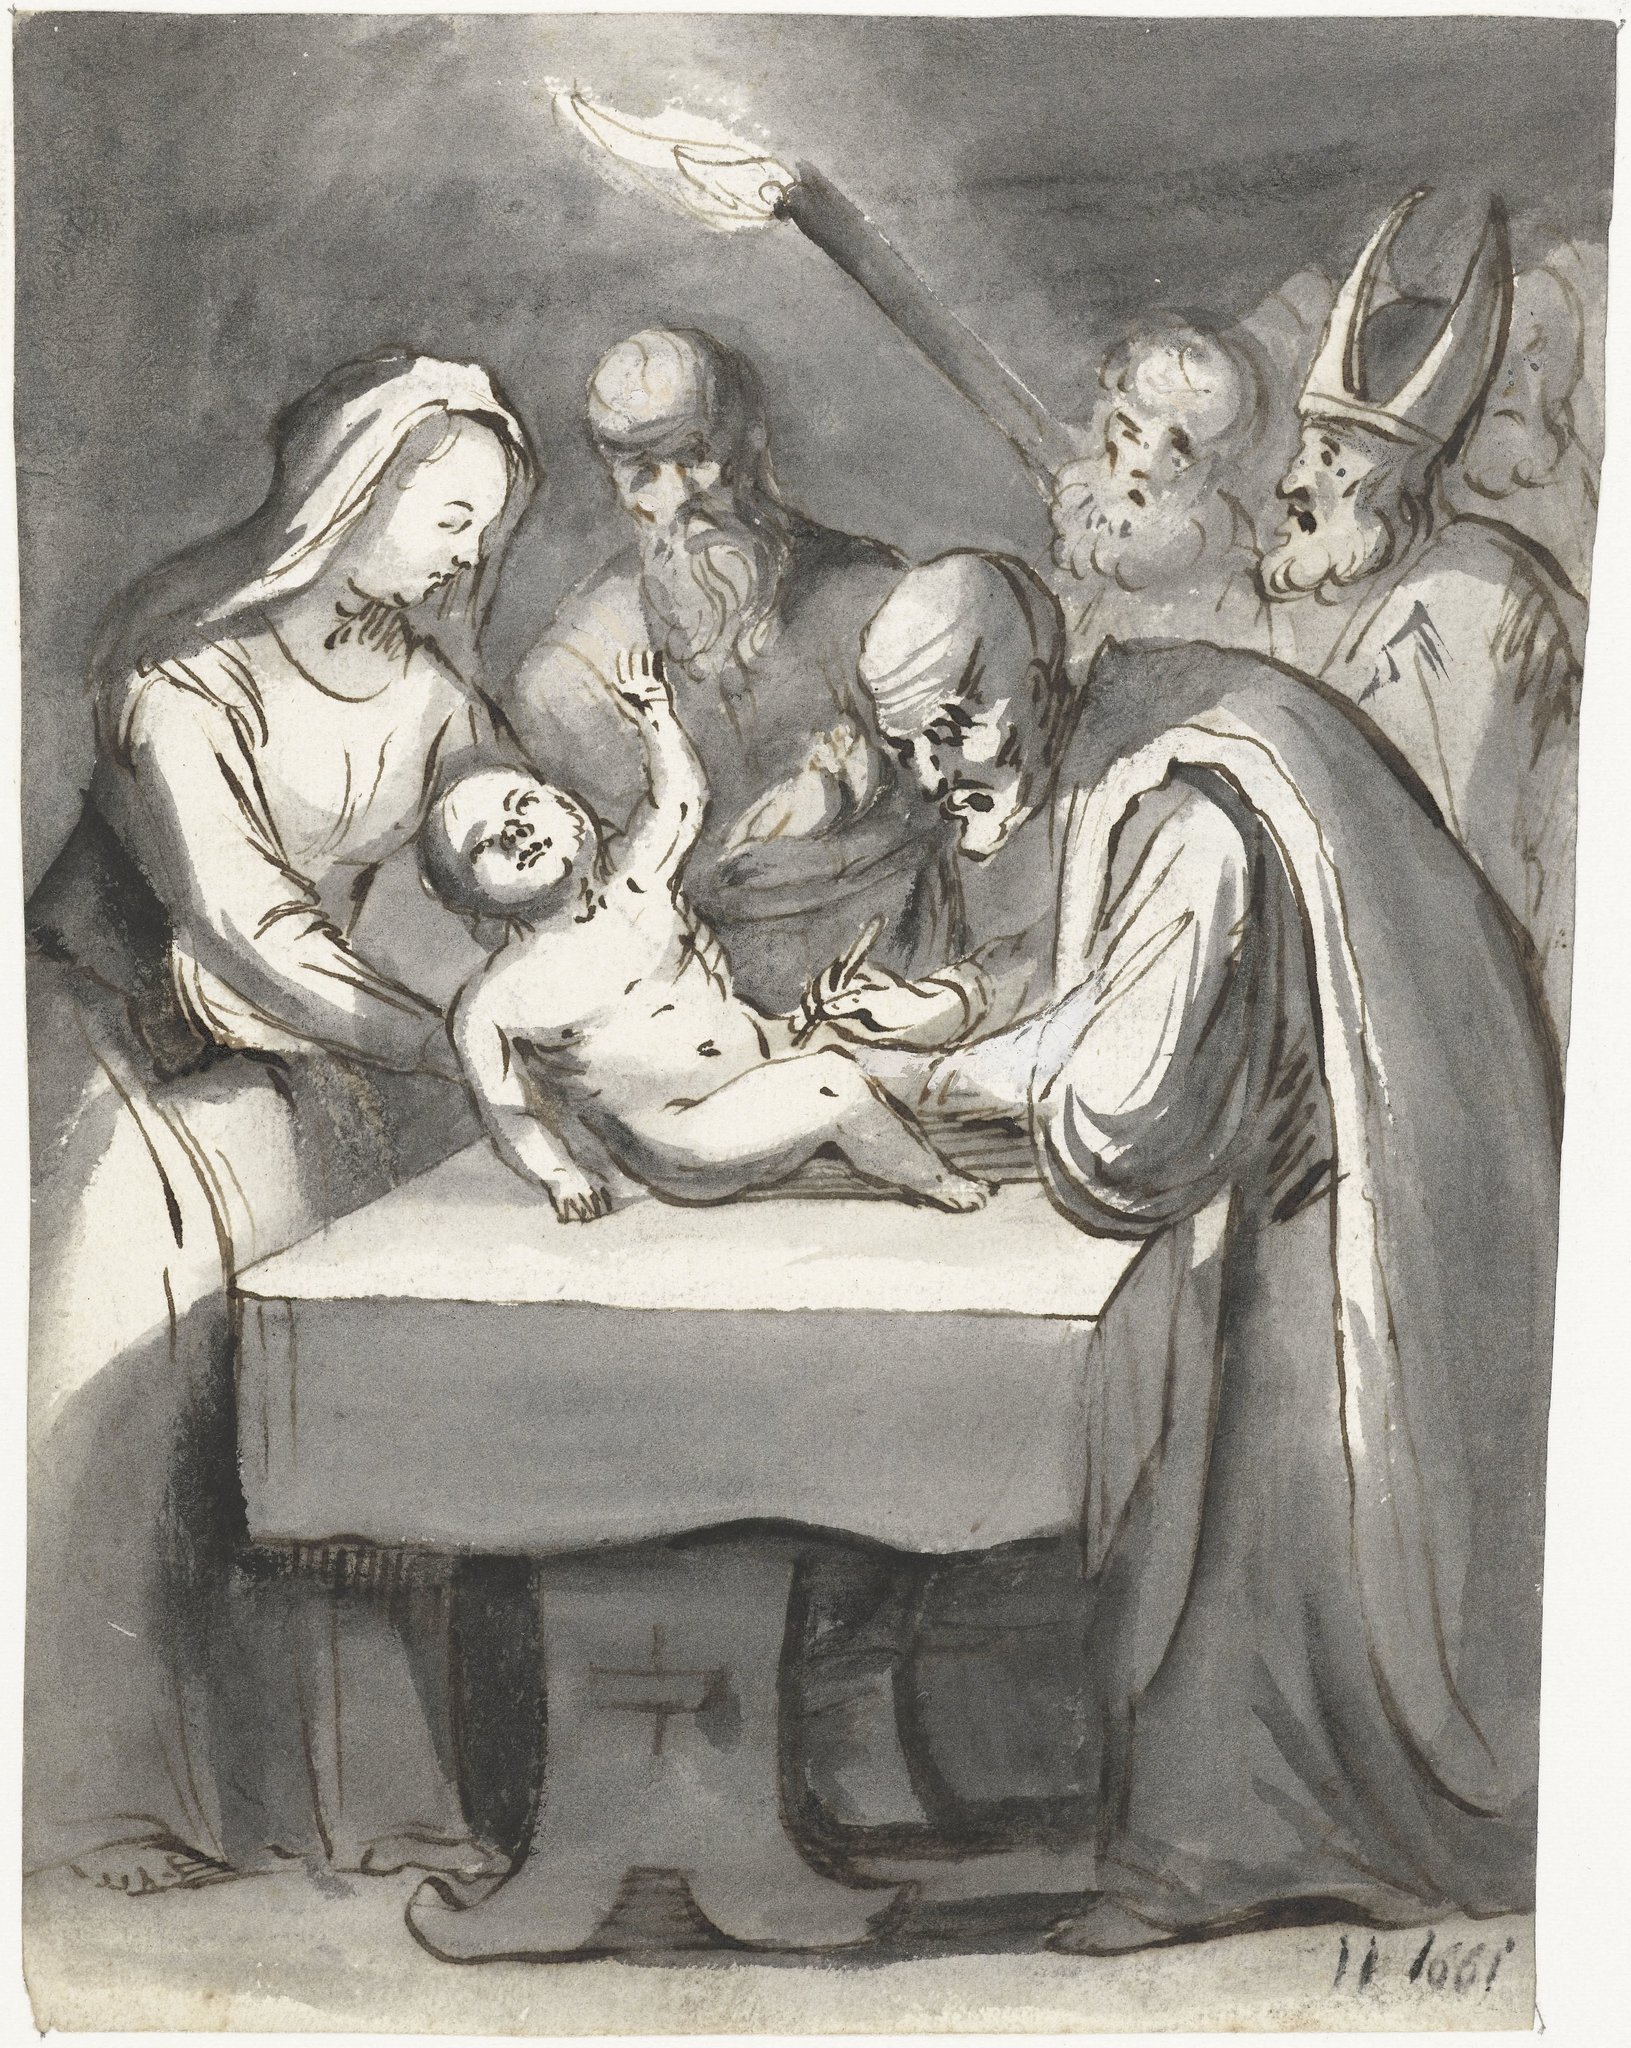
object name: drawing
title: Besnijdenis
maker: moses ter borch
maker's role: draughtsman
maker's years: 1645-1667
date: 1661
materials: paint, gouache, ink, paper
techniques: brush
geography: zwolle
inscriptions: date: ‘1661’, annotation: ‘11’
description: Waarschijnlijk onderdeel van een serie tekeningen met het Nieuwe Testament als onderwerp, M 112-121 en Scrapbook folio's 77, 133 en 149.